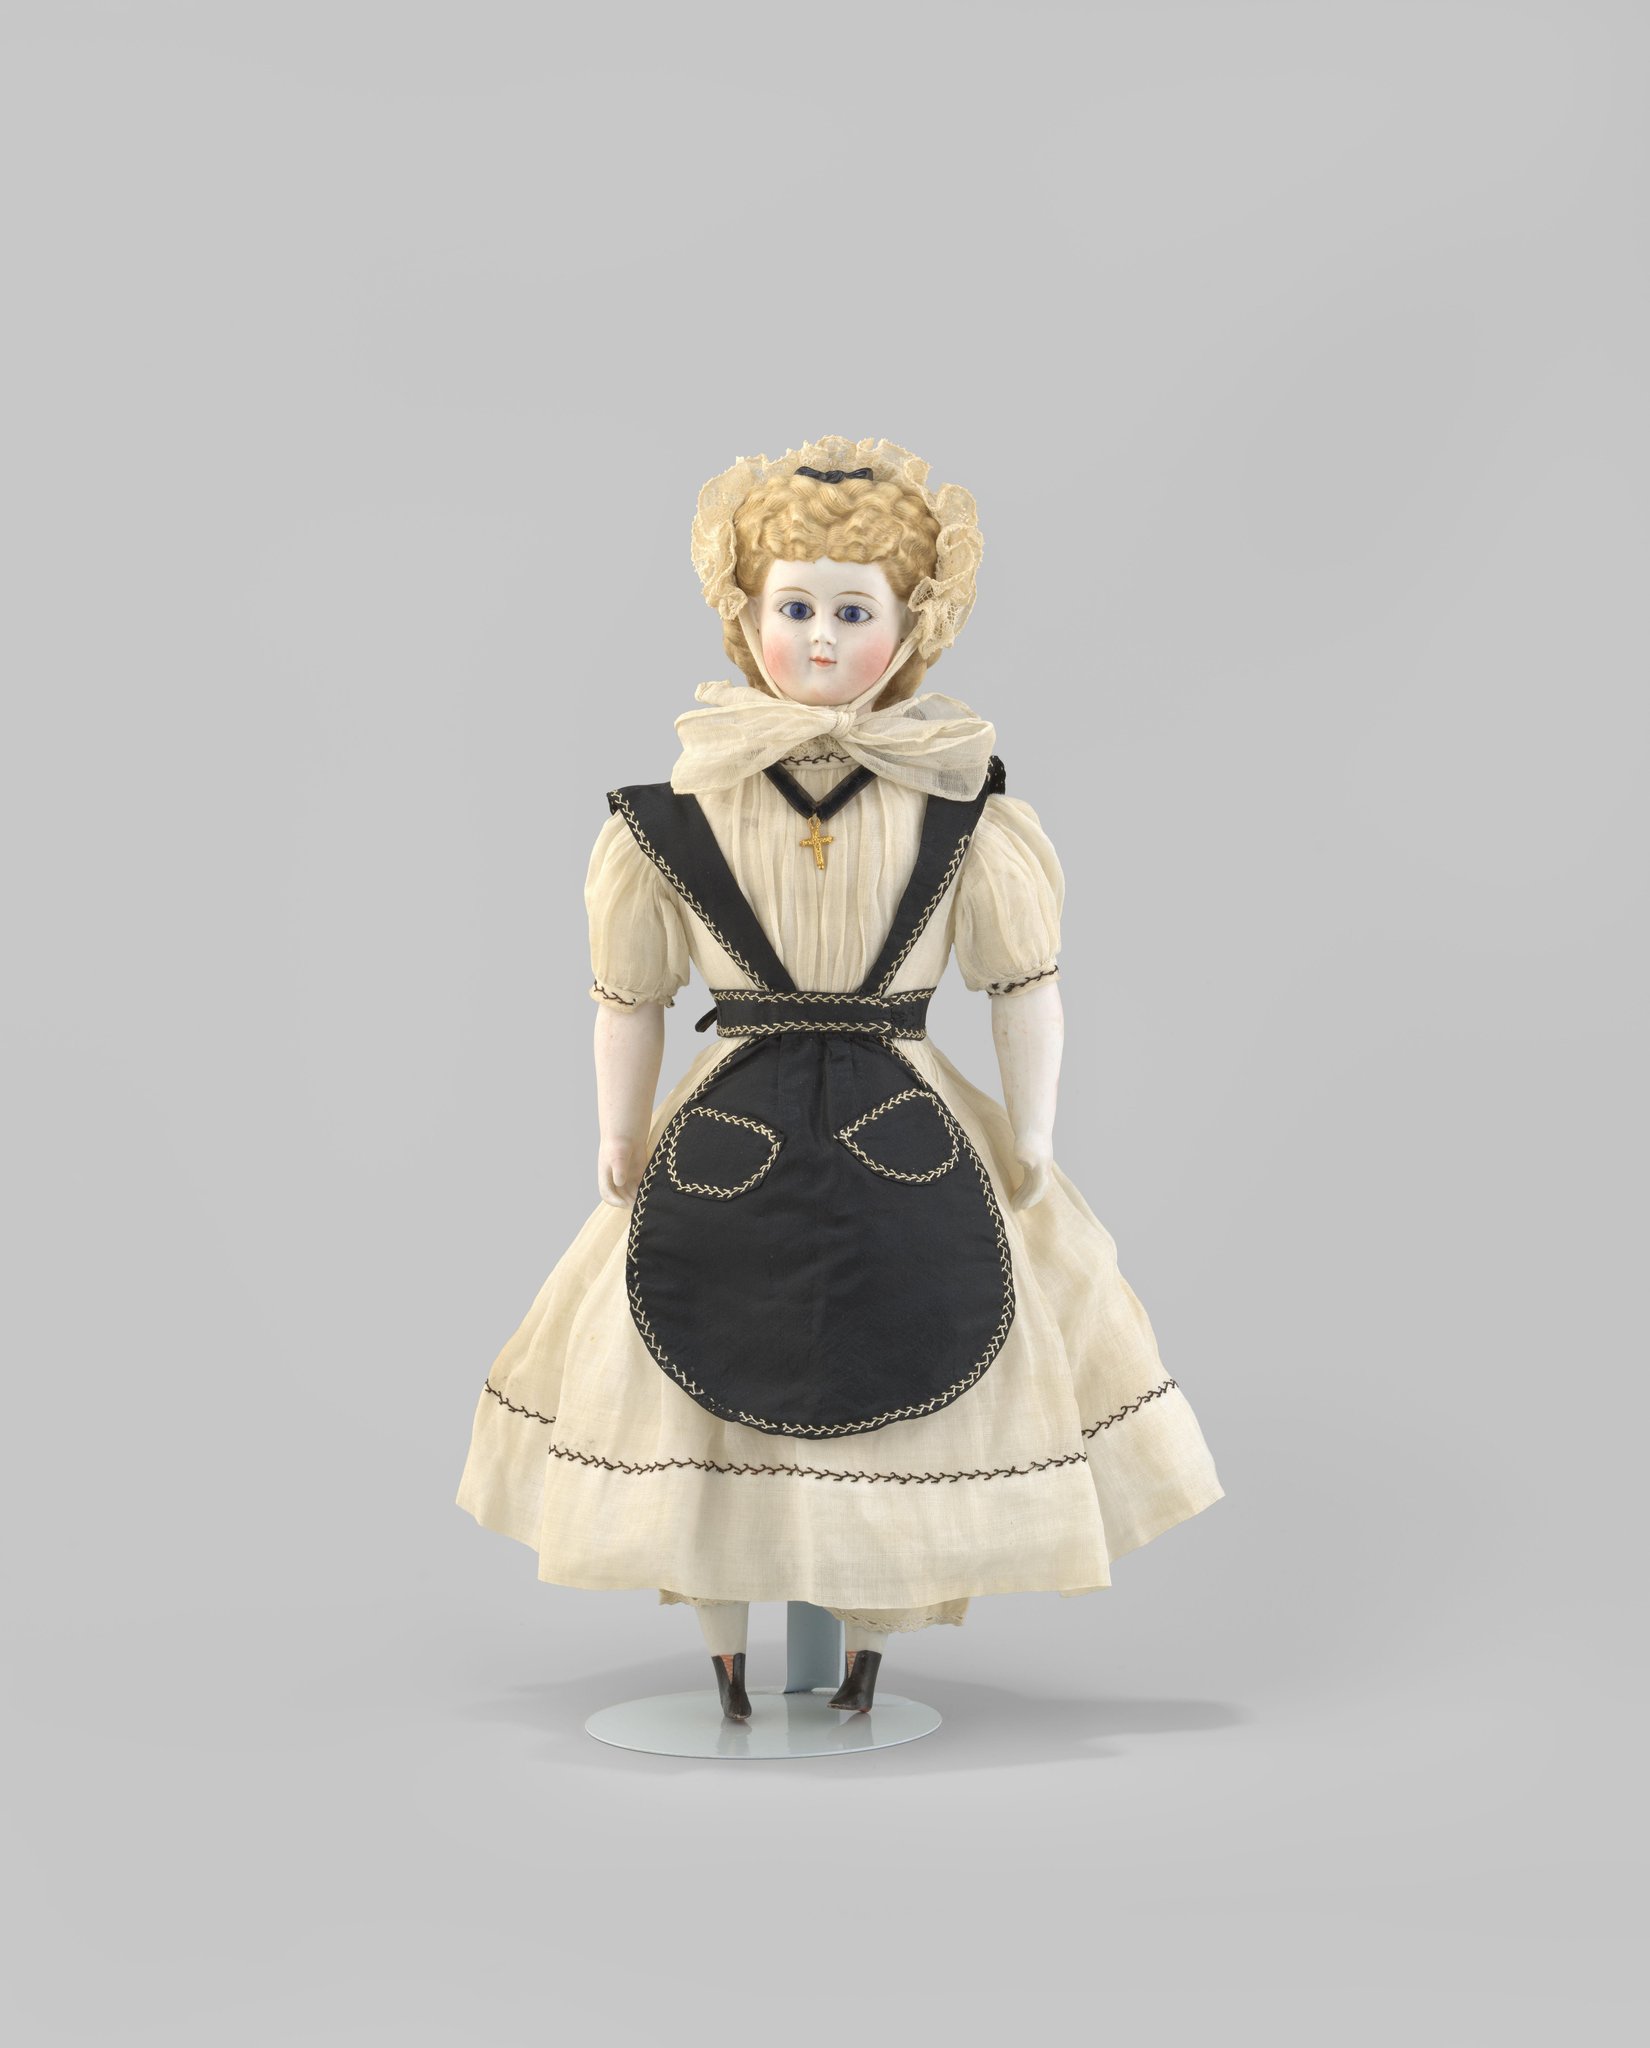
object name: clothing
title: Pop met porseleinen hoofd en blond haar met zwarte laarsjes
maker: Anonymous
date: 1880-1950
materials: hair, porcelain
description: Pop met porseleinen hoofd, lichtblond hoofdhaar en zwarte haarstrik, porseleinen benen met zwartgelakte laarsjes waarin een rode veter. Uitzet bestaande uit 41 stuks. Eén duim ontbreekt.